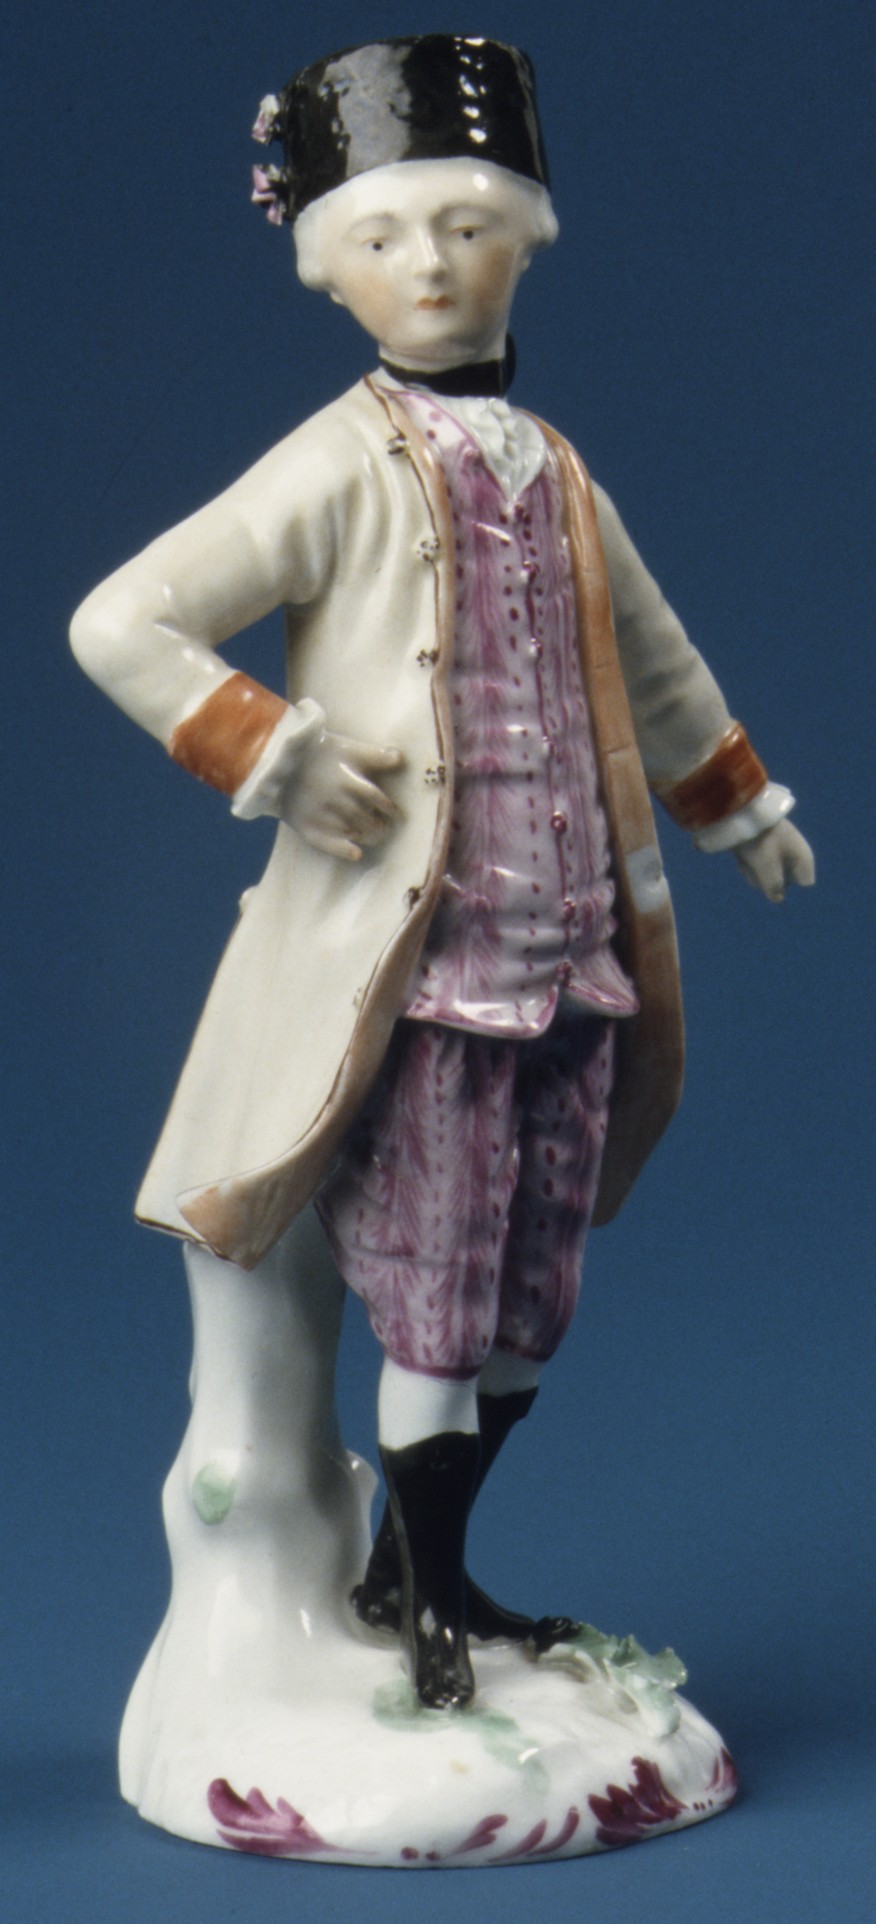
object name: figure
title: Child (one of a pair)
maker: fulda pottery and porcelain manufactory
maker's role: manufactory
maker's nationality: german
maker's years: 1764-1789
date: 1781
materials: hard paste porcelain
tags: boys